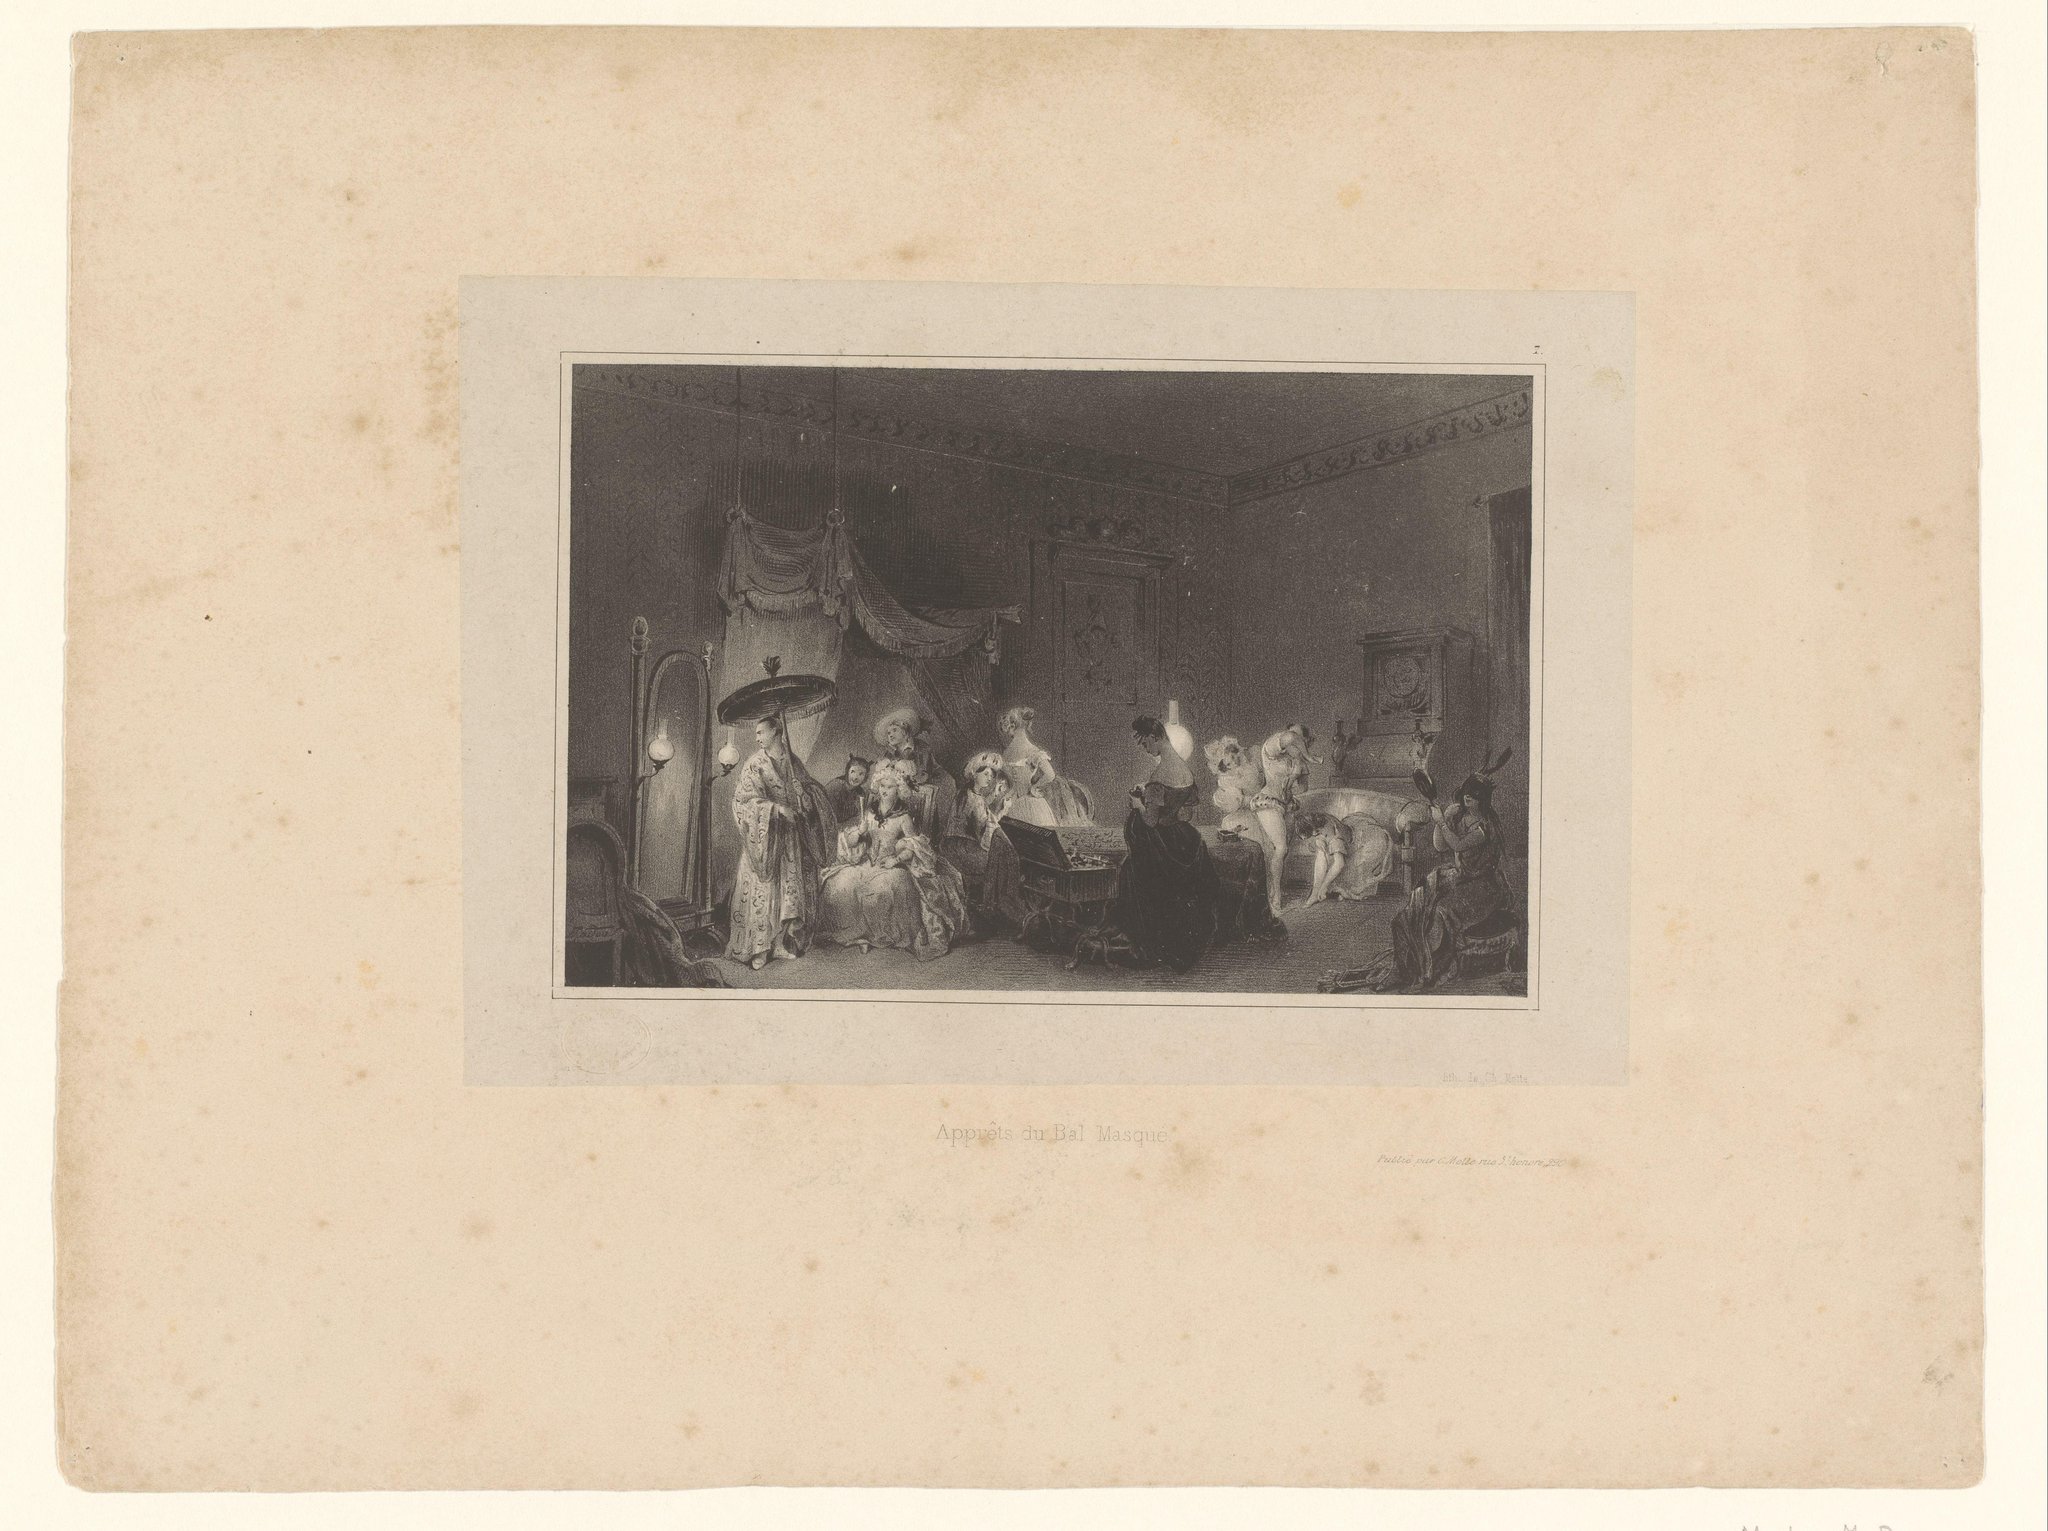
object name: print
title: Apprêts du bal masque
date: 1833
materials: paper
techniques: lithograph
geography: paris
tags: lacing up a corset, masquerade, masked ball, interior of the house, dressing and undressing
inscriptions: collector's mark: Lugt 2228, check stamp: Lugt 1828b